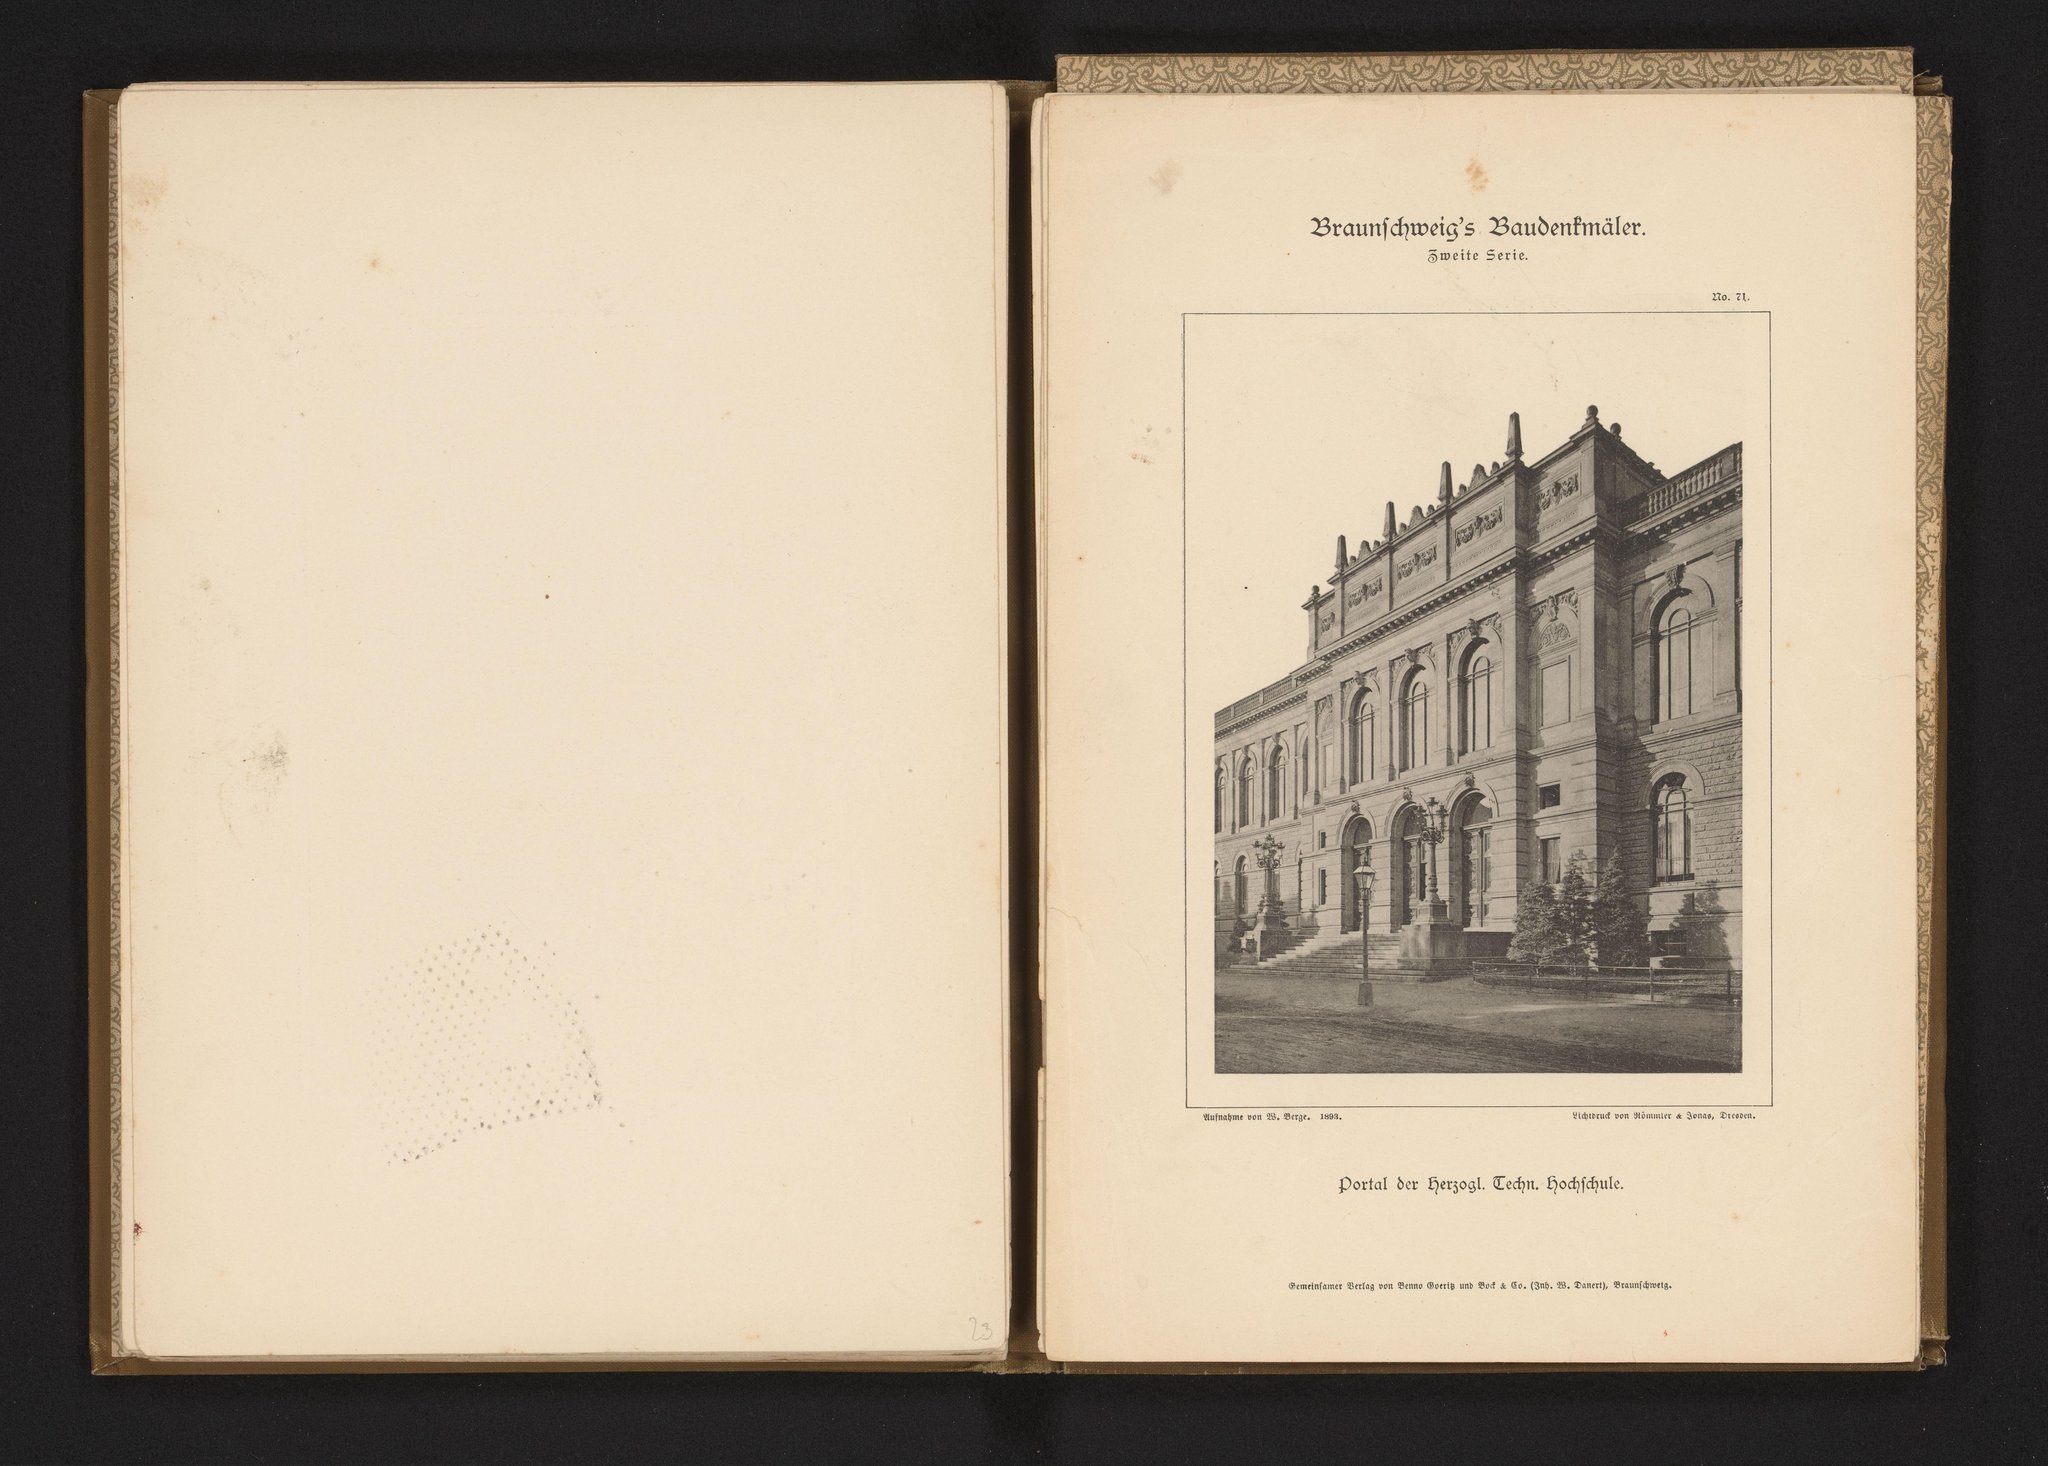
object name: page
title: Braunschweig's Baudenkmäler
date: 1893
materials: paper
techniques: photograph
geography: braunschweig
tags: secondary education, façade (of house or building)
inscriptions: number: ‘No. 71.’